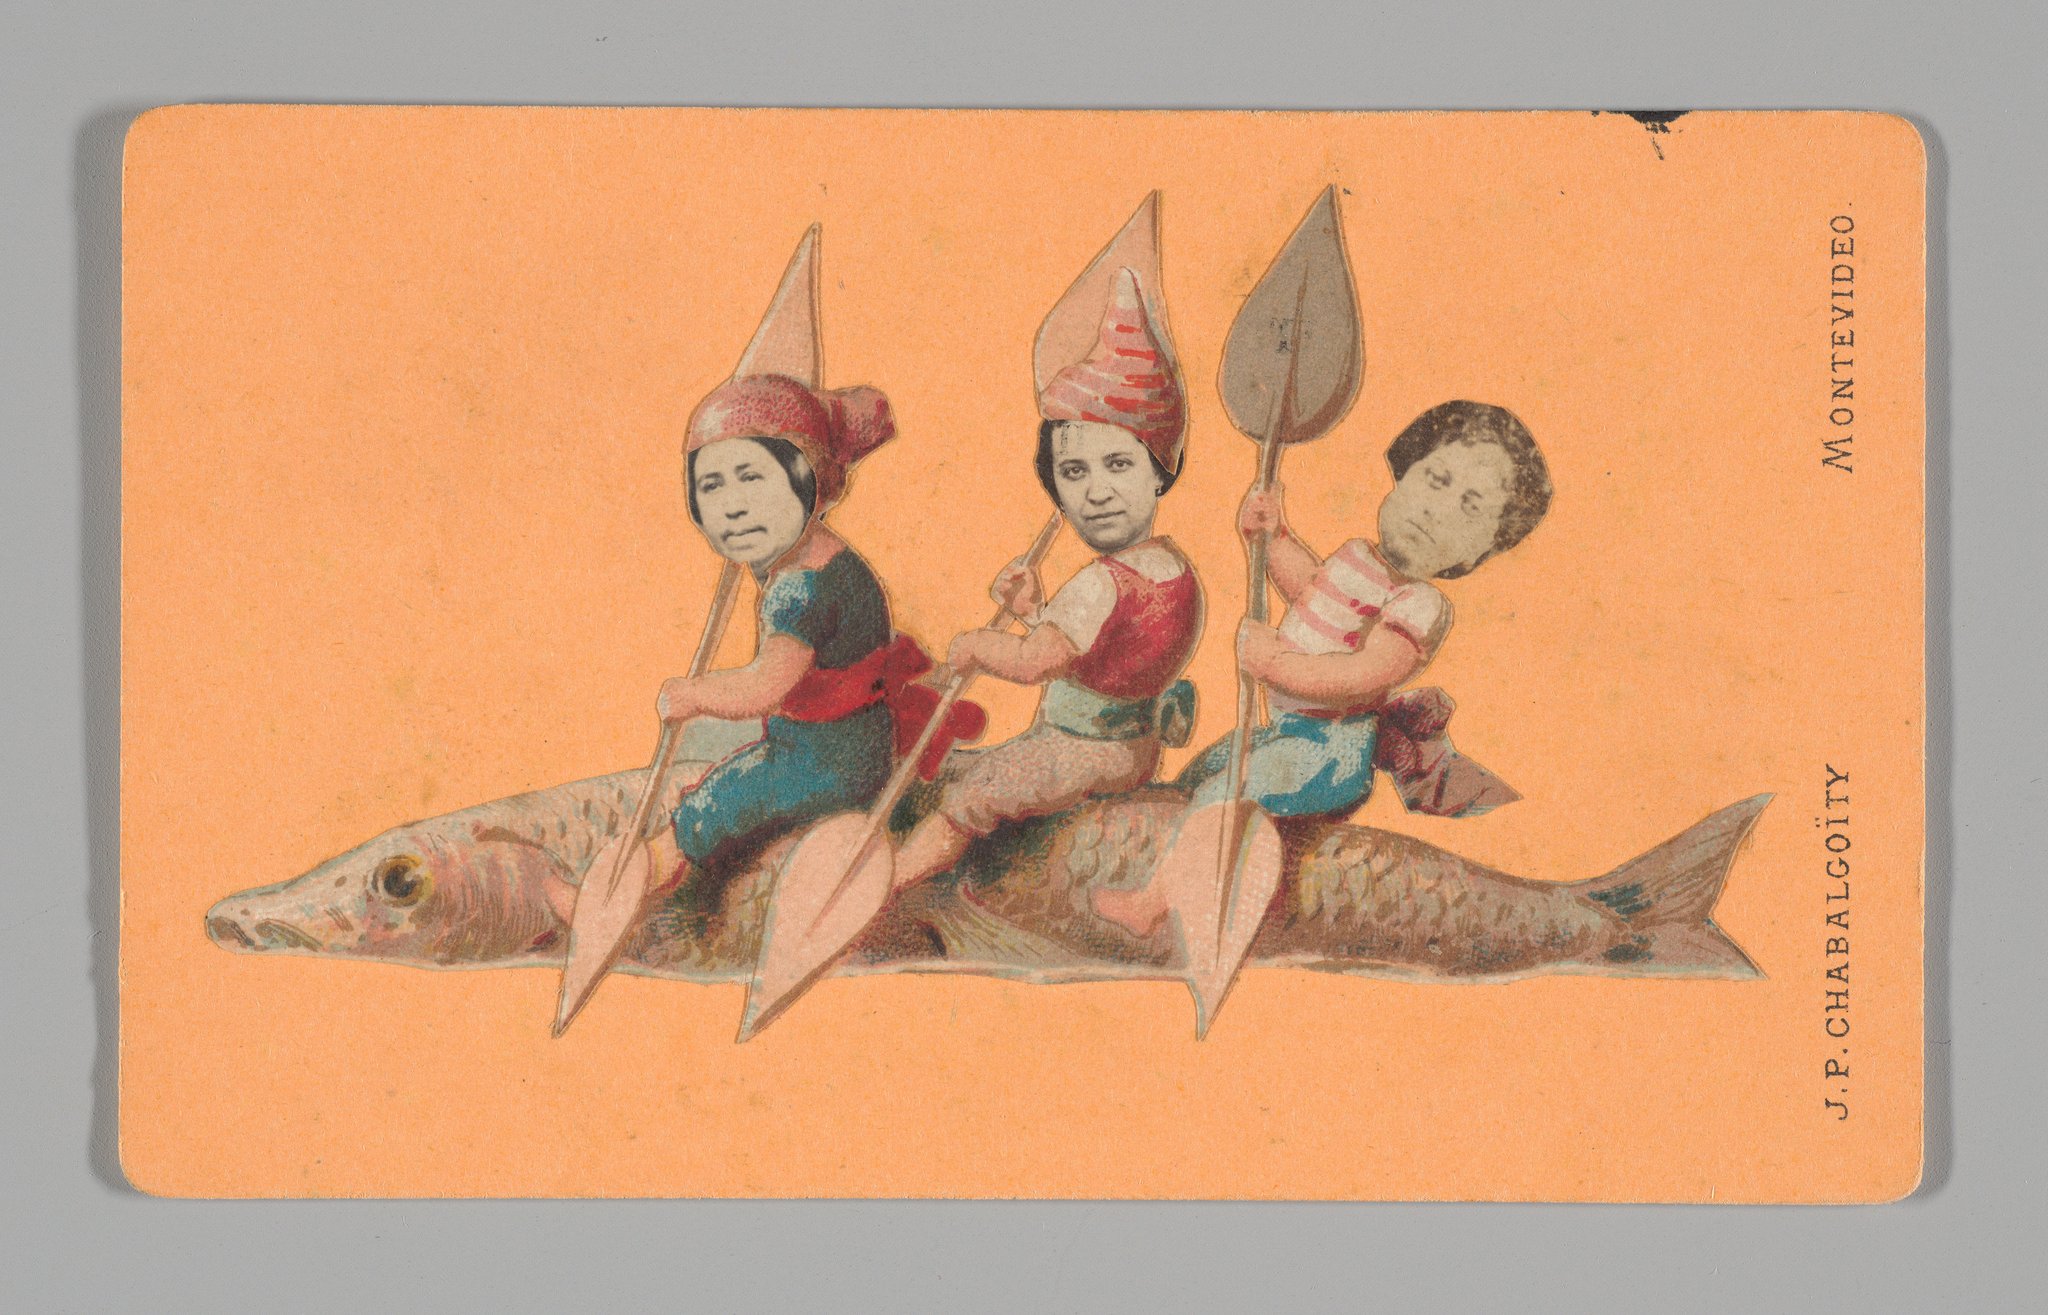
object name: carte de visite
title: [Photo Collage: Three People Holding Oars, Sitting on a Large Fish]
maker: juan pedro chabalgoity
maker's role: artist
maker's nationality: uruguayan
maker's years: 1848-1909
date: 1875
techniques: albumen silver print, lithograph